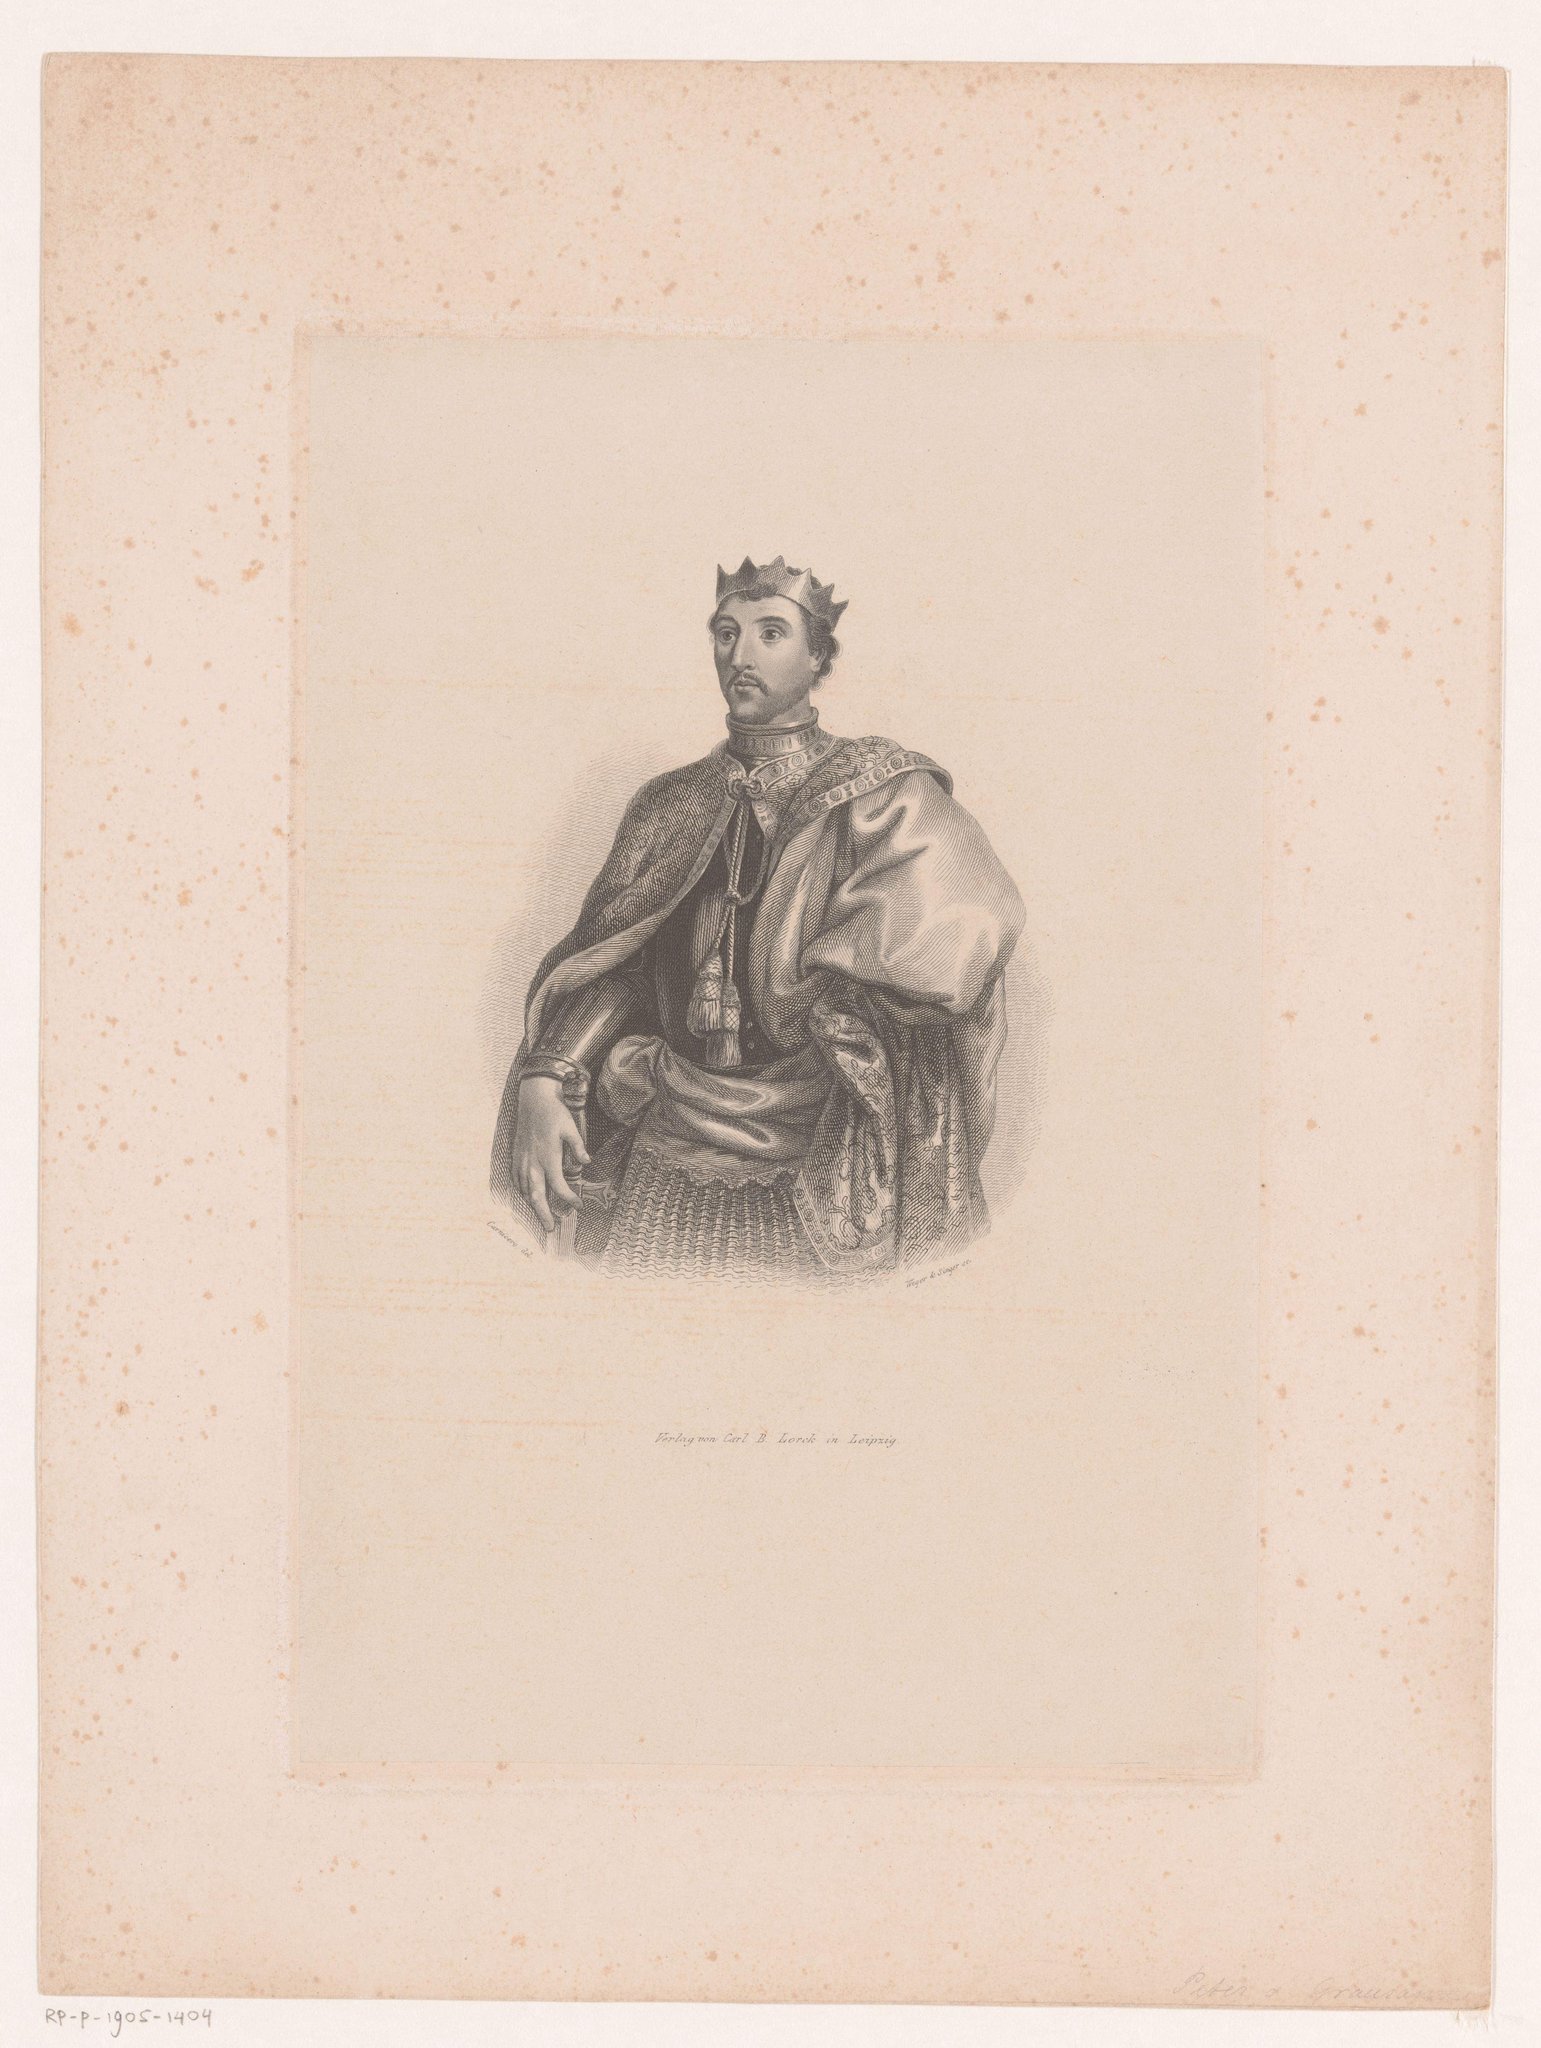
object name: print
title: Portret van Peter I, koning van Castilië en Leon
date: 1849-1892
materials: paper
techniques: engraving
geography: leipzig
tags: historical persons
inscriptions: collector's mark: Lugt 2228